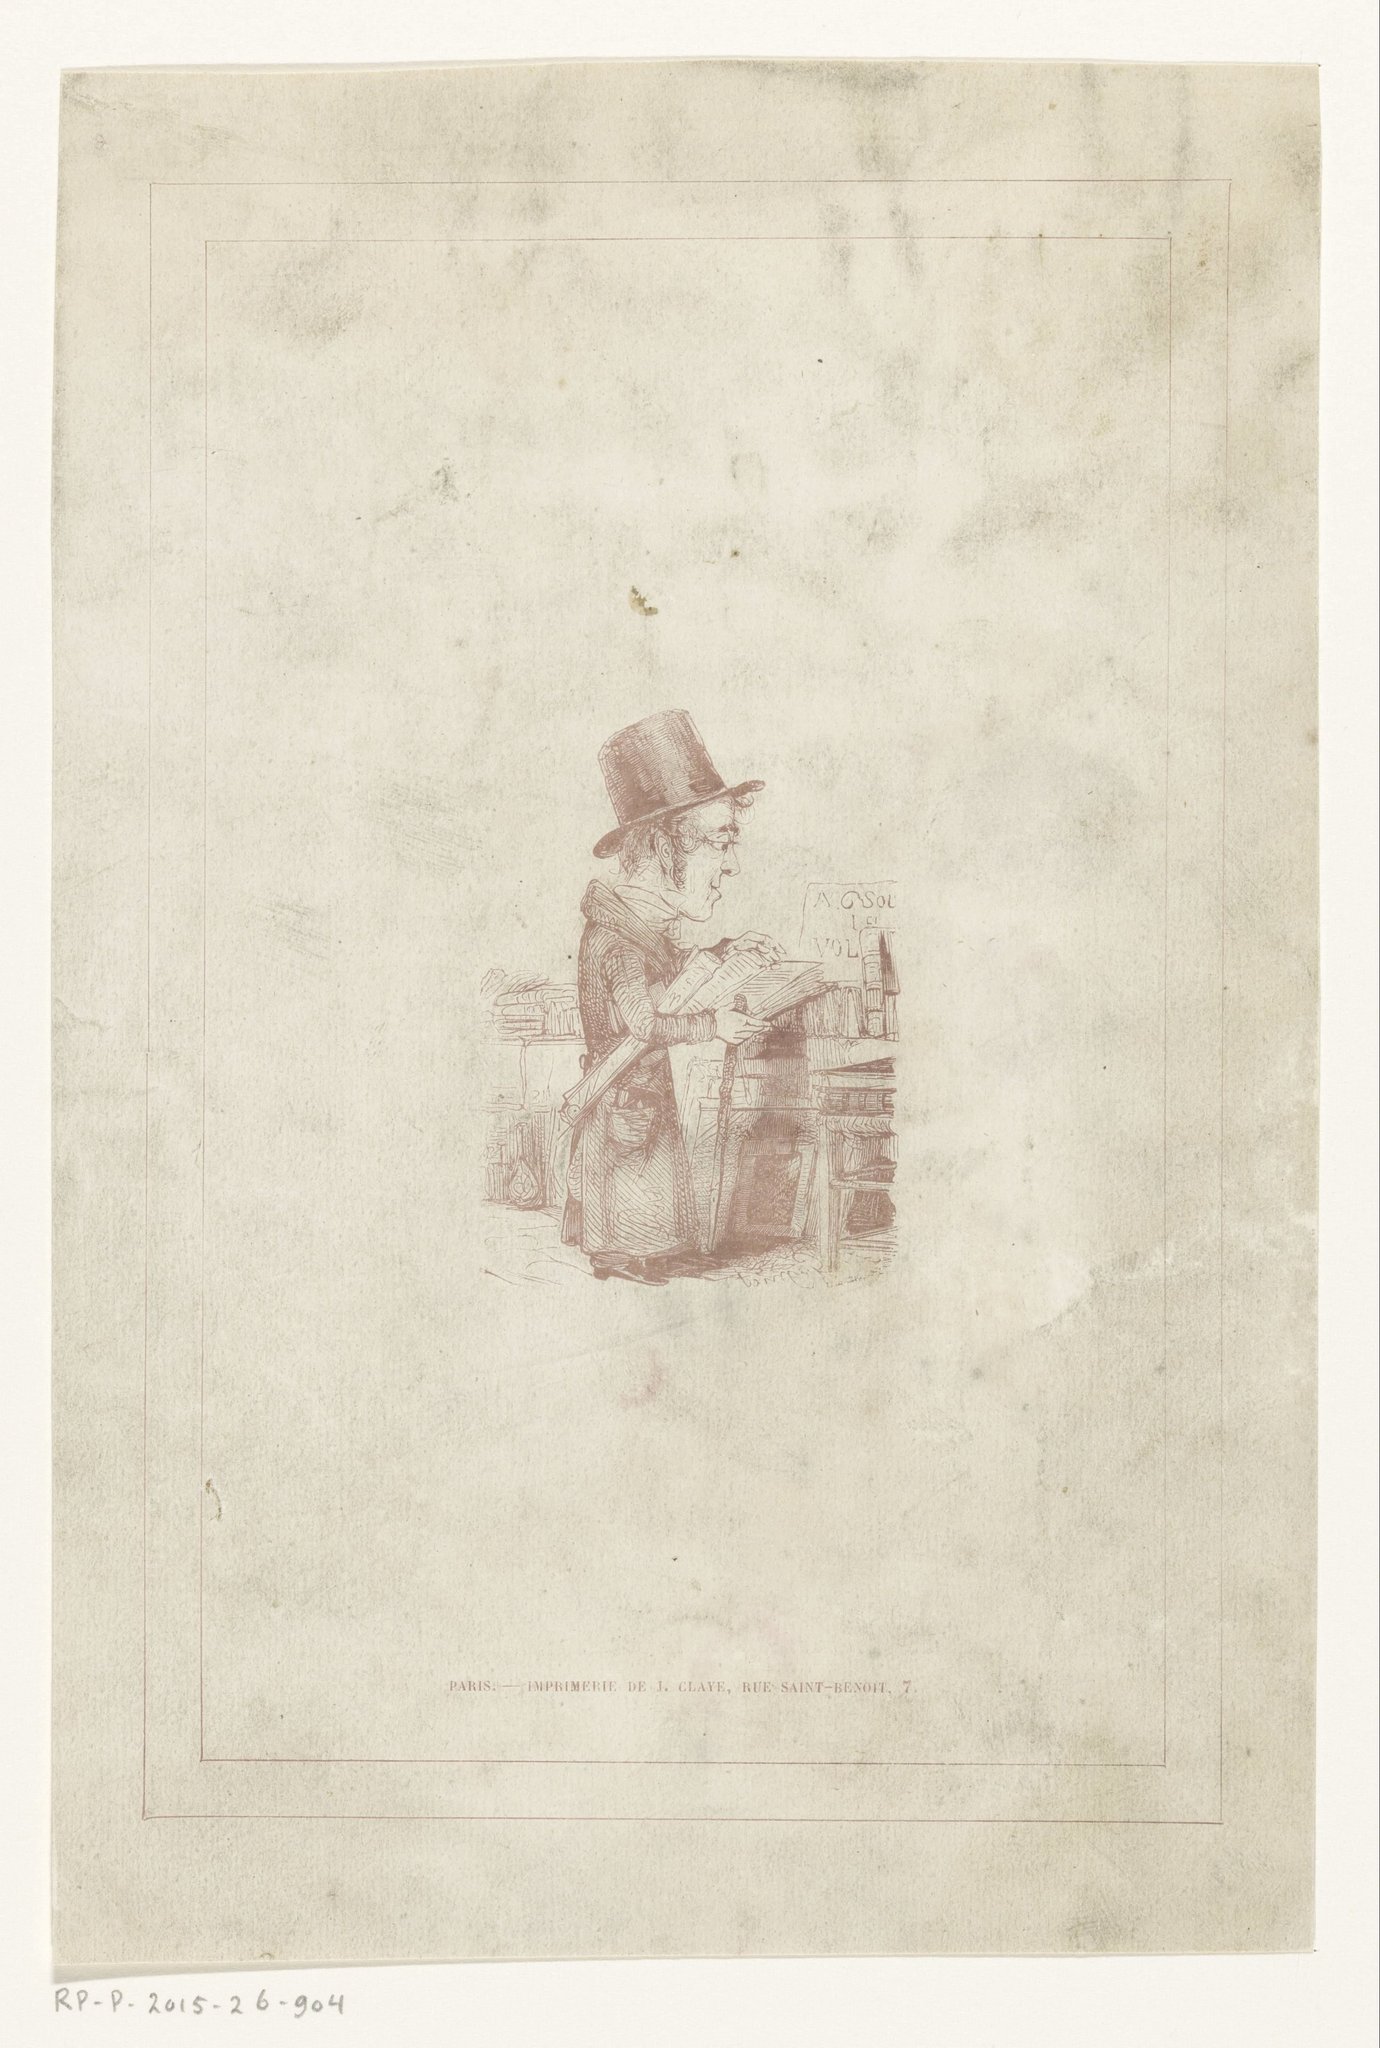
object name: print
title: Man bekijkt een boek voor een boekenkraam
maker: jules alexandre saturnin claye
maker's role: printer, publisher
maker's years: 1806-1886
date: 1830-1864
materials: paper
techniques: lithograph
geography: paris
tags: book-stall, kiosk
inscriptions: collector's mark: Lugt 2228, collector's mark: Lugt 4779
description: Op de kraam een bordje met 'a 6 sol le vol'.